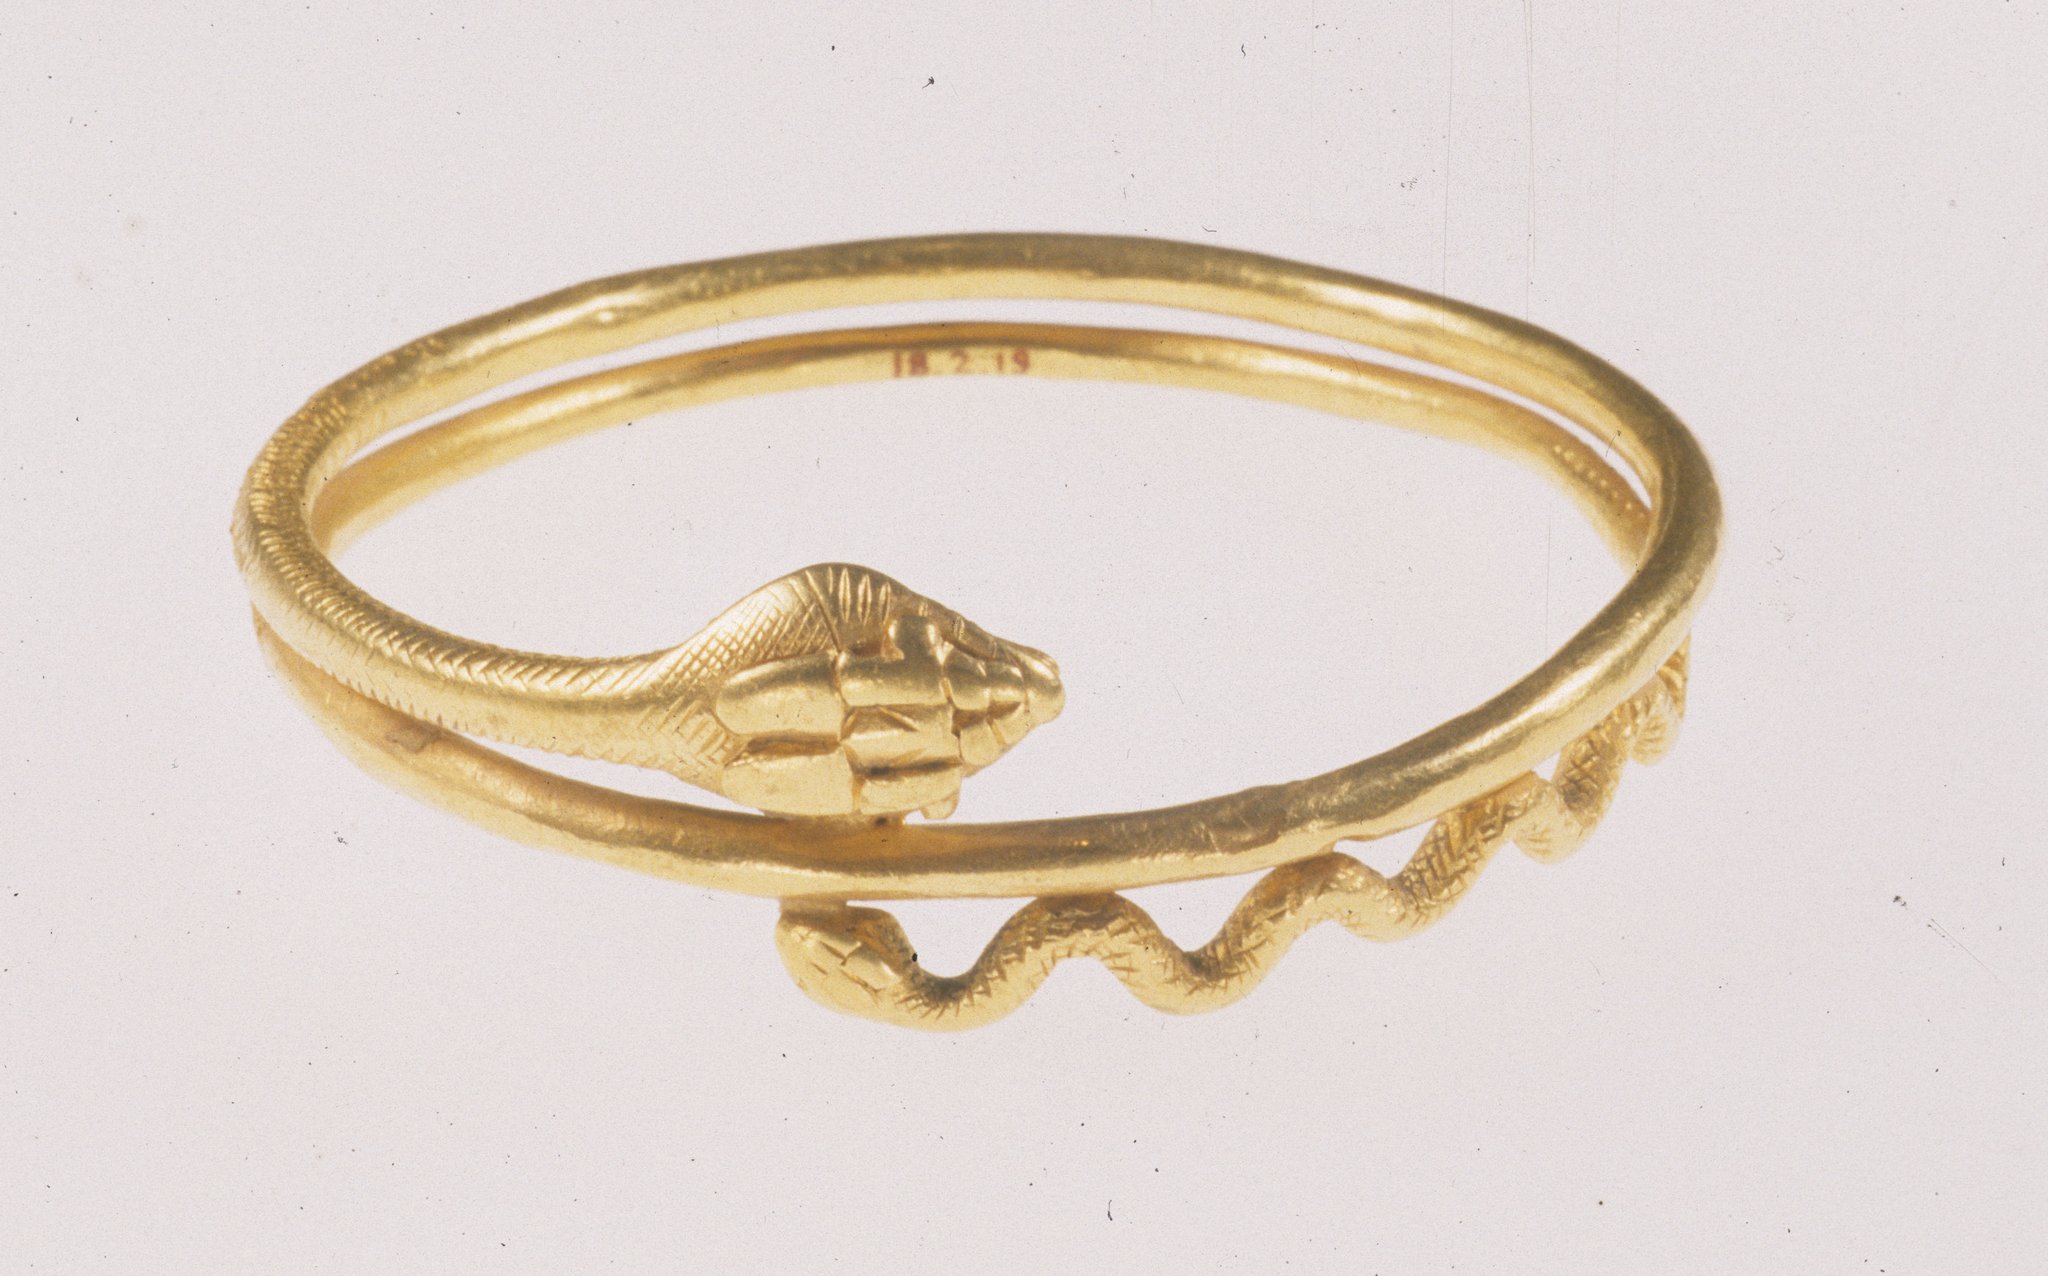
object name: bracelet, snake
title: Snake bracelet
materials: gold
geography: egypt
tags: snakes